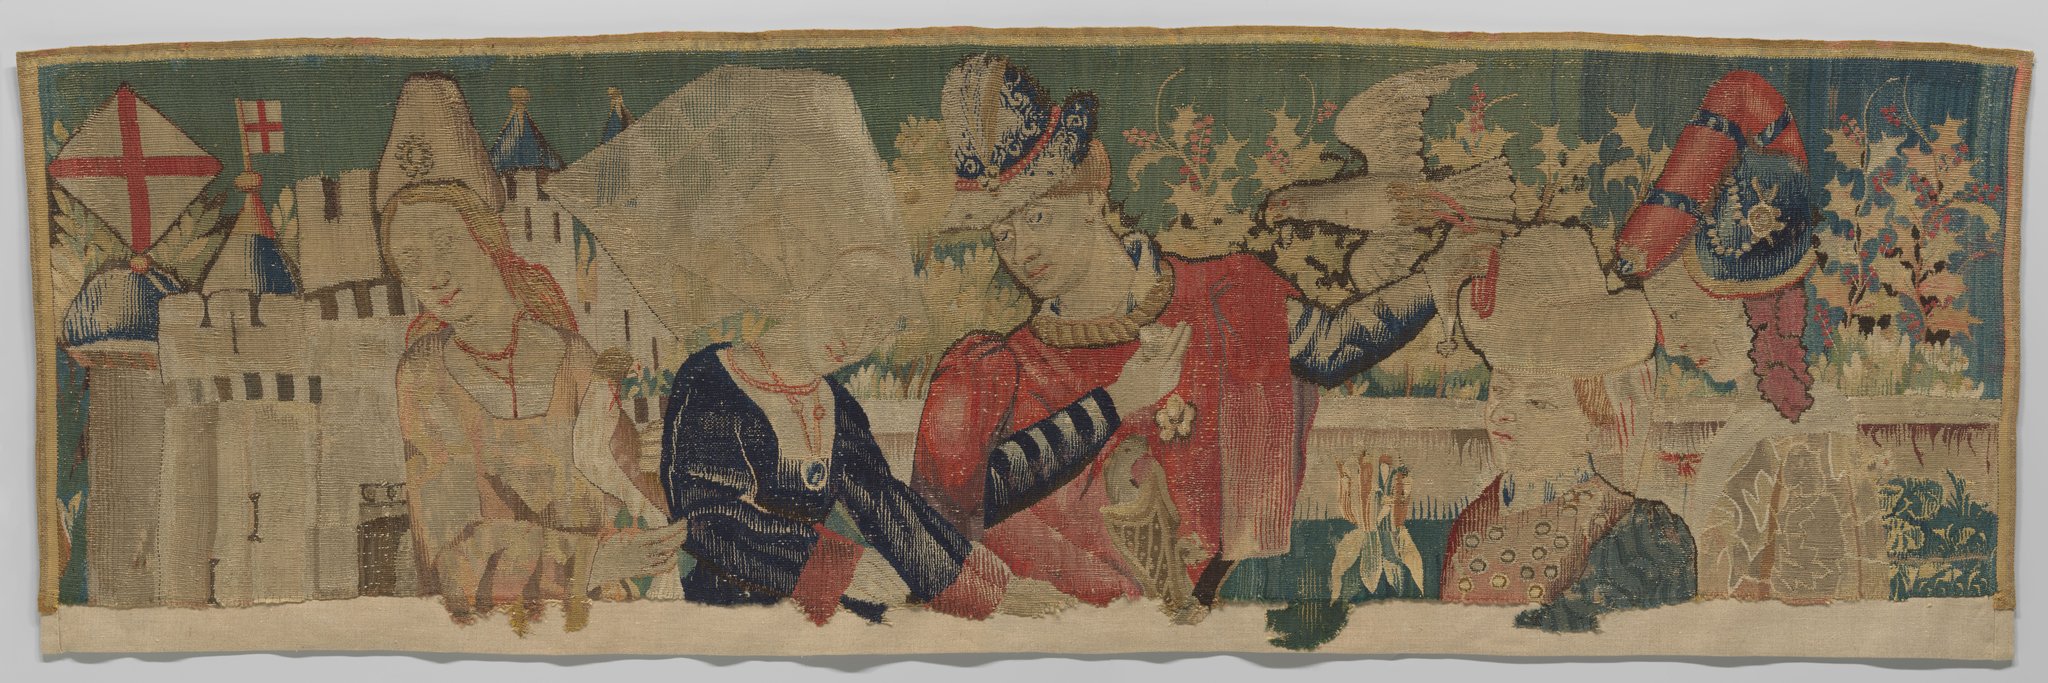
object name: tapestry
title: Valkenjacht (fragment)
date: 1450-1460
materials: wool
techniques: tapestry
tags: earl, charles the bold (duke of burgundy), lille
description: Tapestry (fragment). Charles the Bold and Margaret of York hawking (?). Wool, silk. Southern Netherlands, c. 1470.